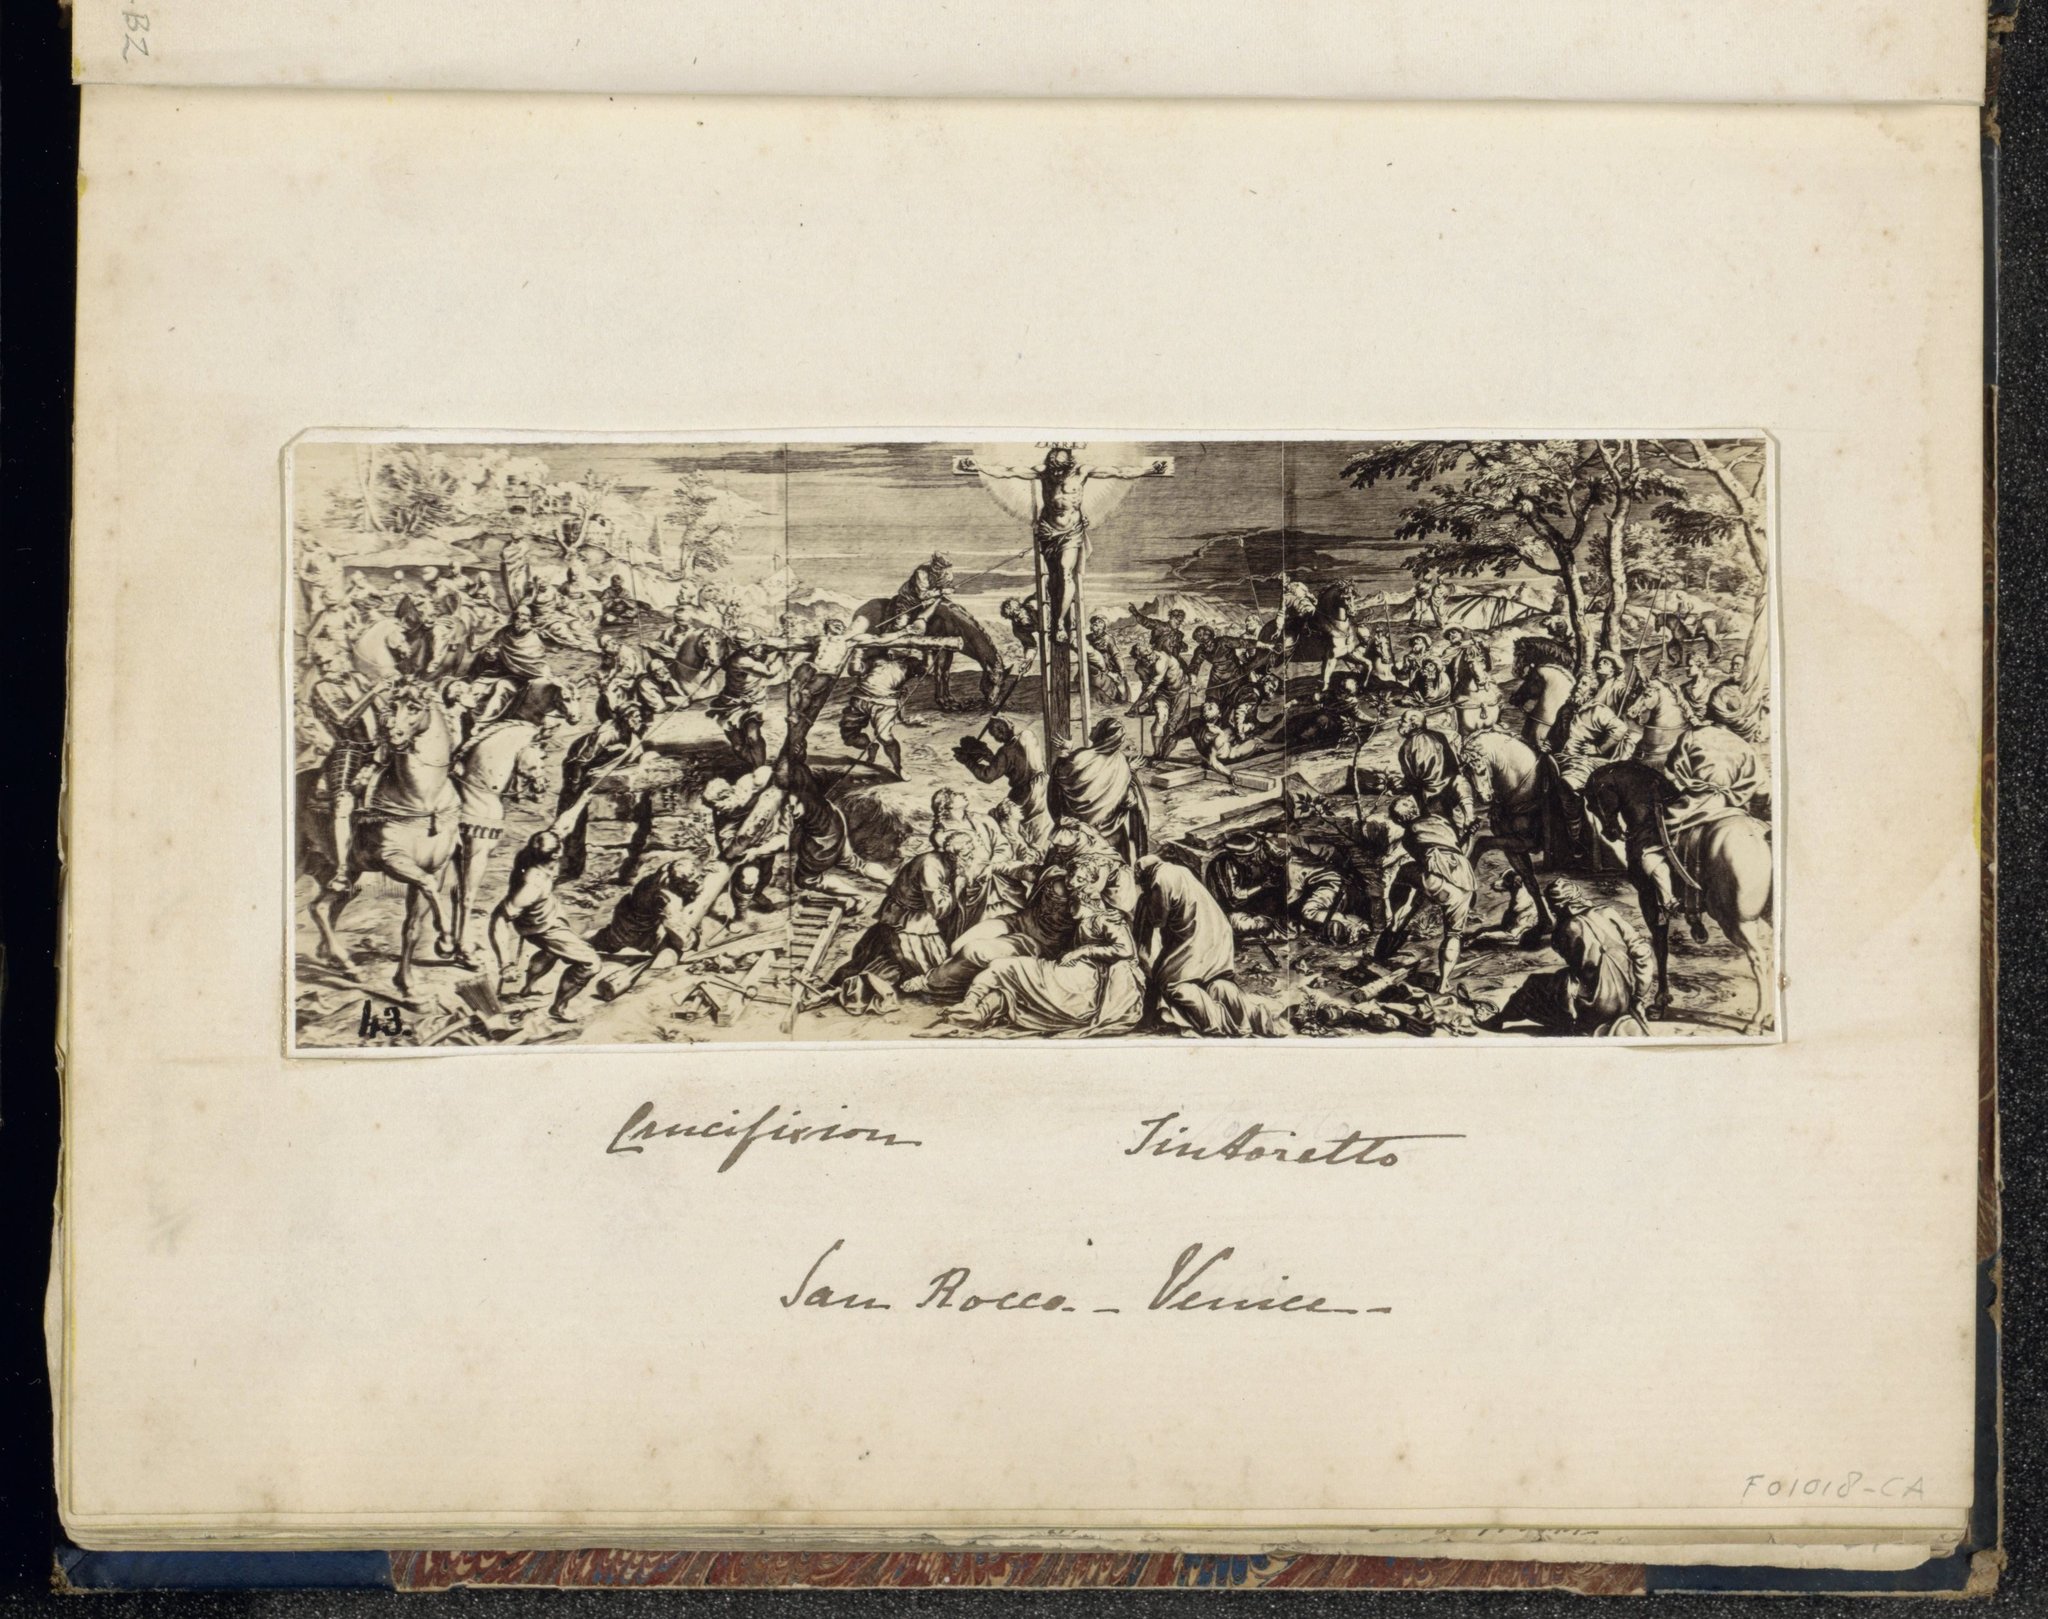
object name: reproduction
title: Crucifixion Tintoretto: San Rocco - Venice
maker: Anonymous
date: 1860-1870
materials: cardboard, paper, photographic support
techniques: albumen print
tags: the crucifixion of christ: christ's death on the cross; golgotha (matthew 27:45-58; mark 15:33-45; luke 23:44-52; john 19:25-38)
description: Onderdeel van Engels familiealbum met foto's van personen, reizen, cricket en kunstwerken.